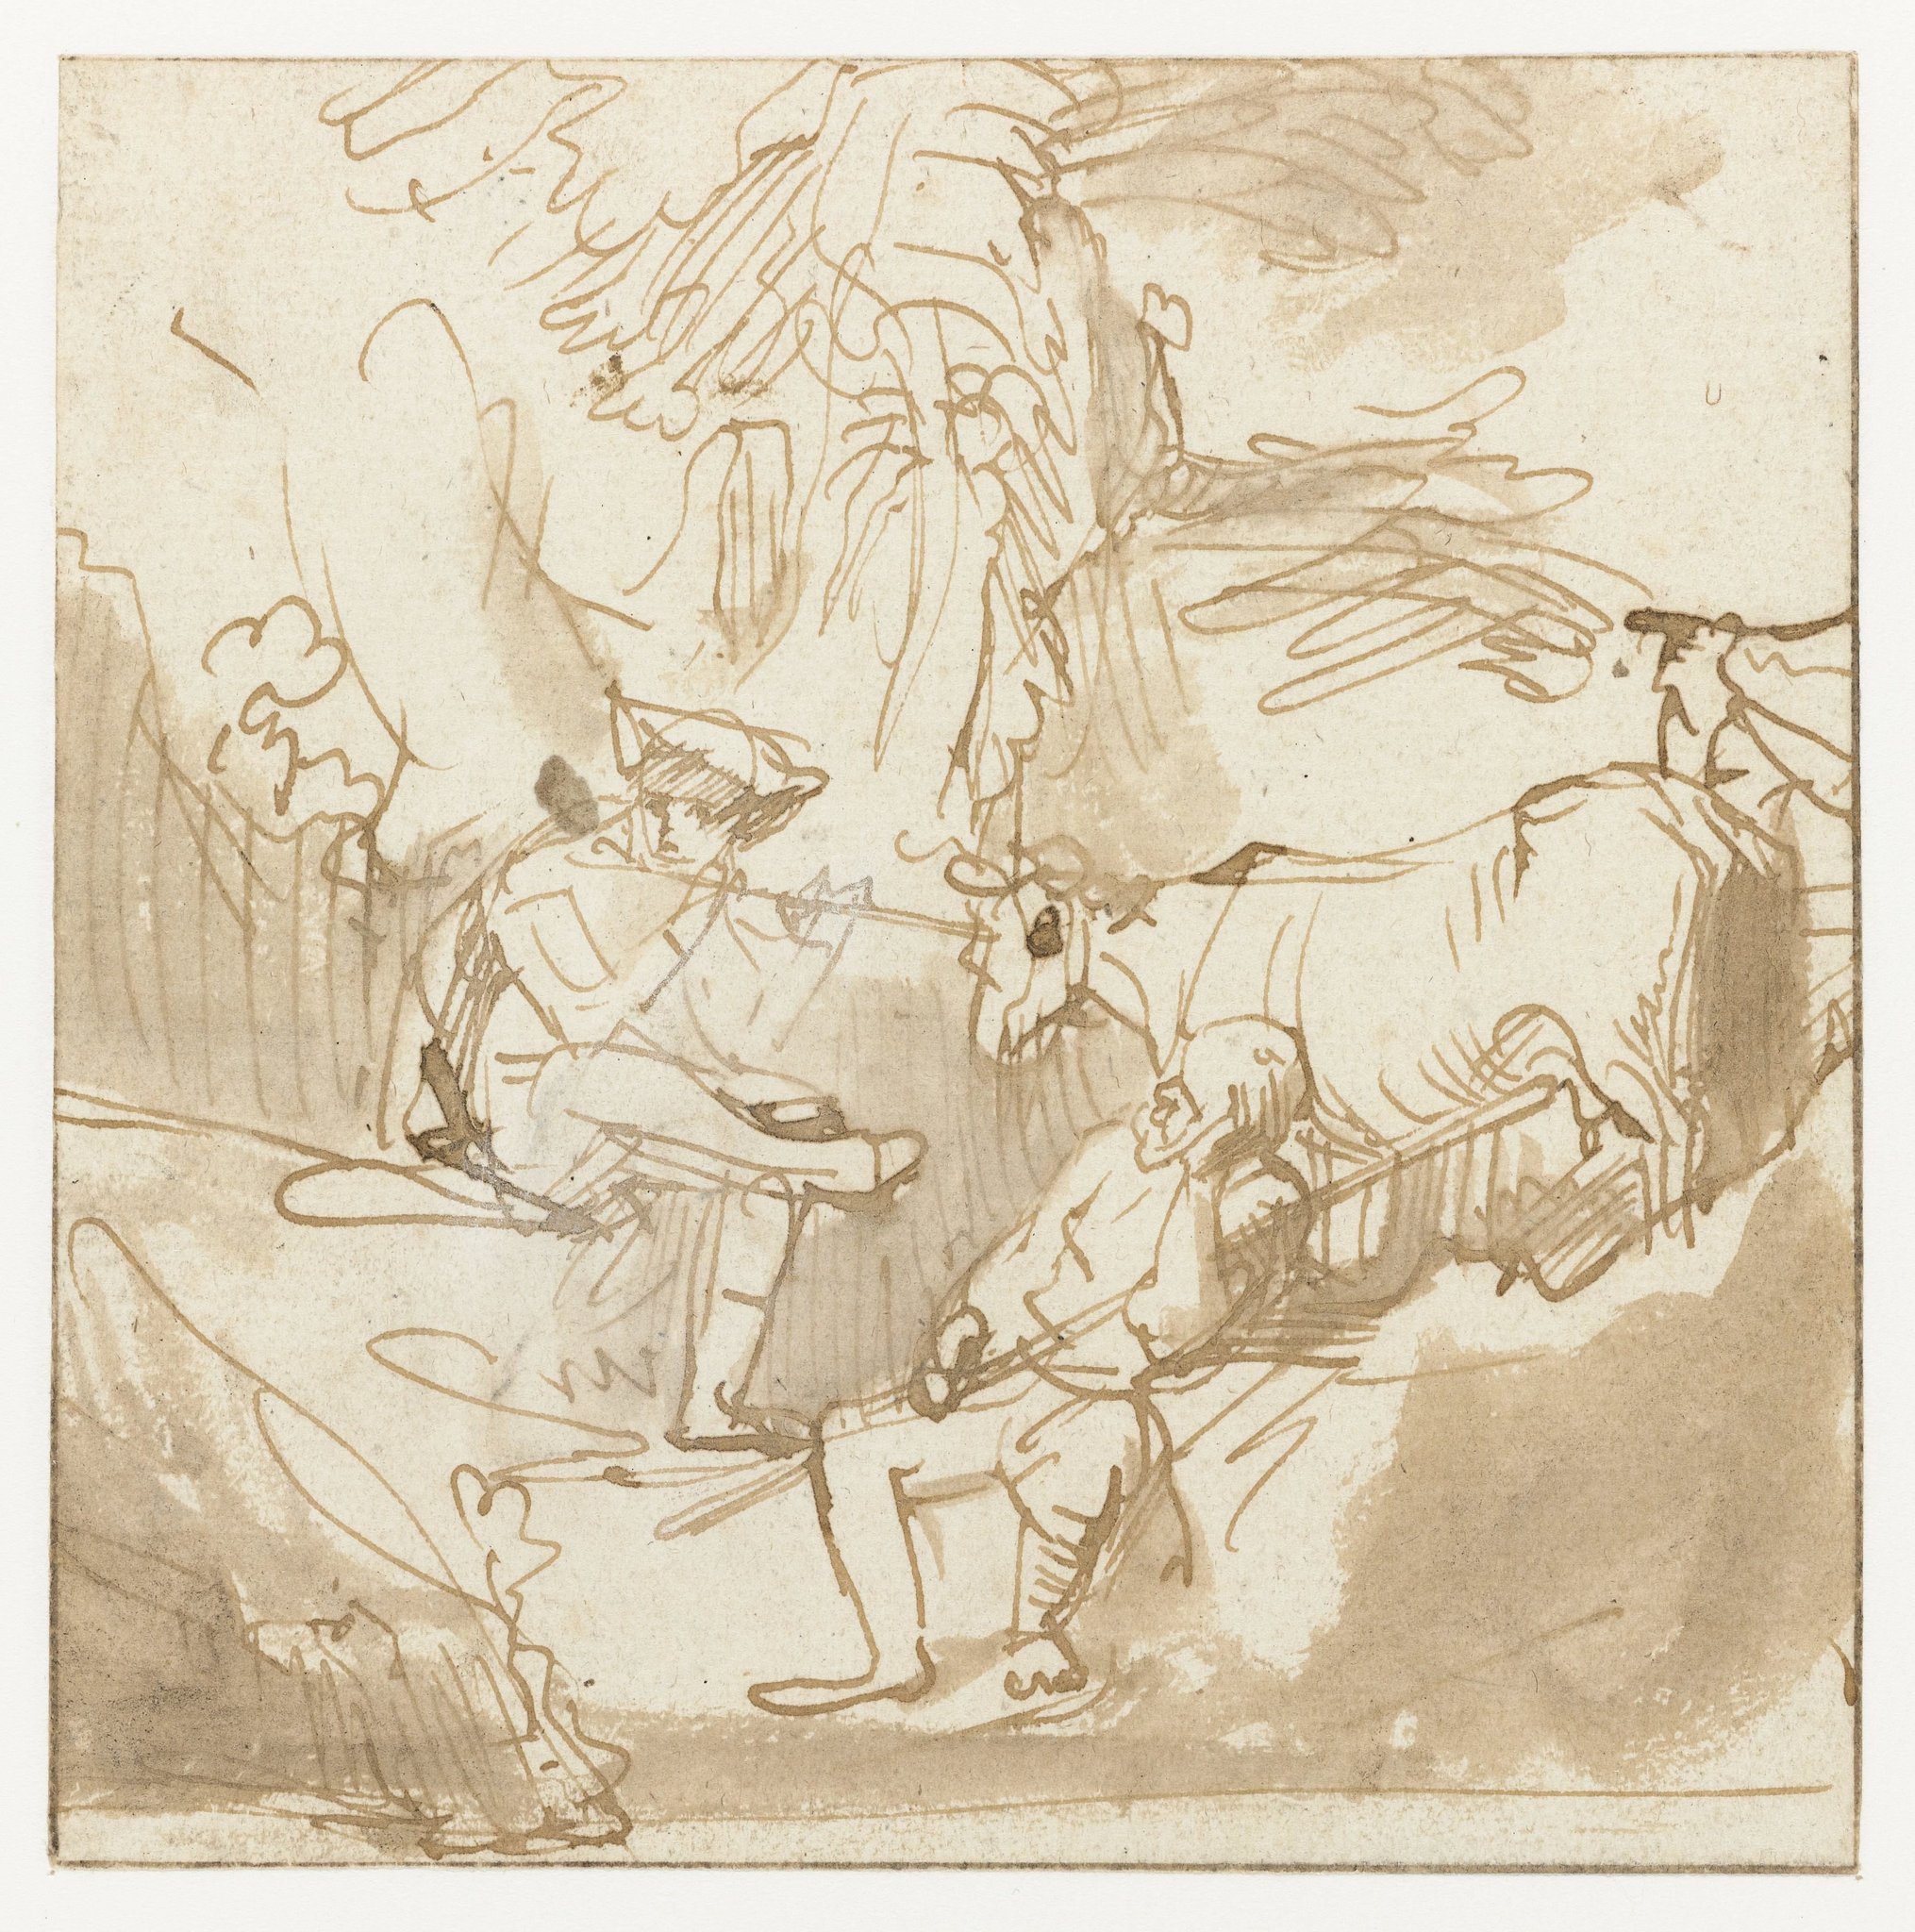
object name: drawing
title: Mercury, Argus and Io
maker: gerbrand van den eeckhout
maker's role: draughtsman, print maker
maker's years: 1621-1674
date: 1650-1674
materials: paint, ink, paper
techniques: brush, pen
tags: (story of) mercury (hermes)